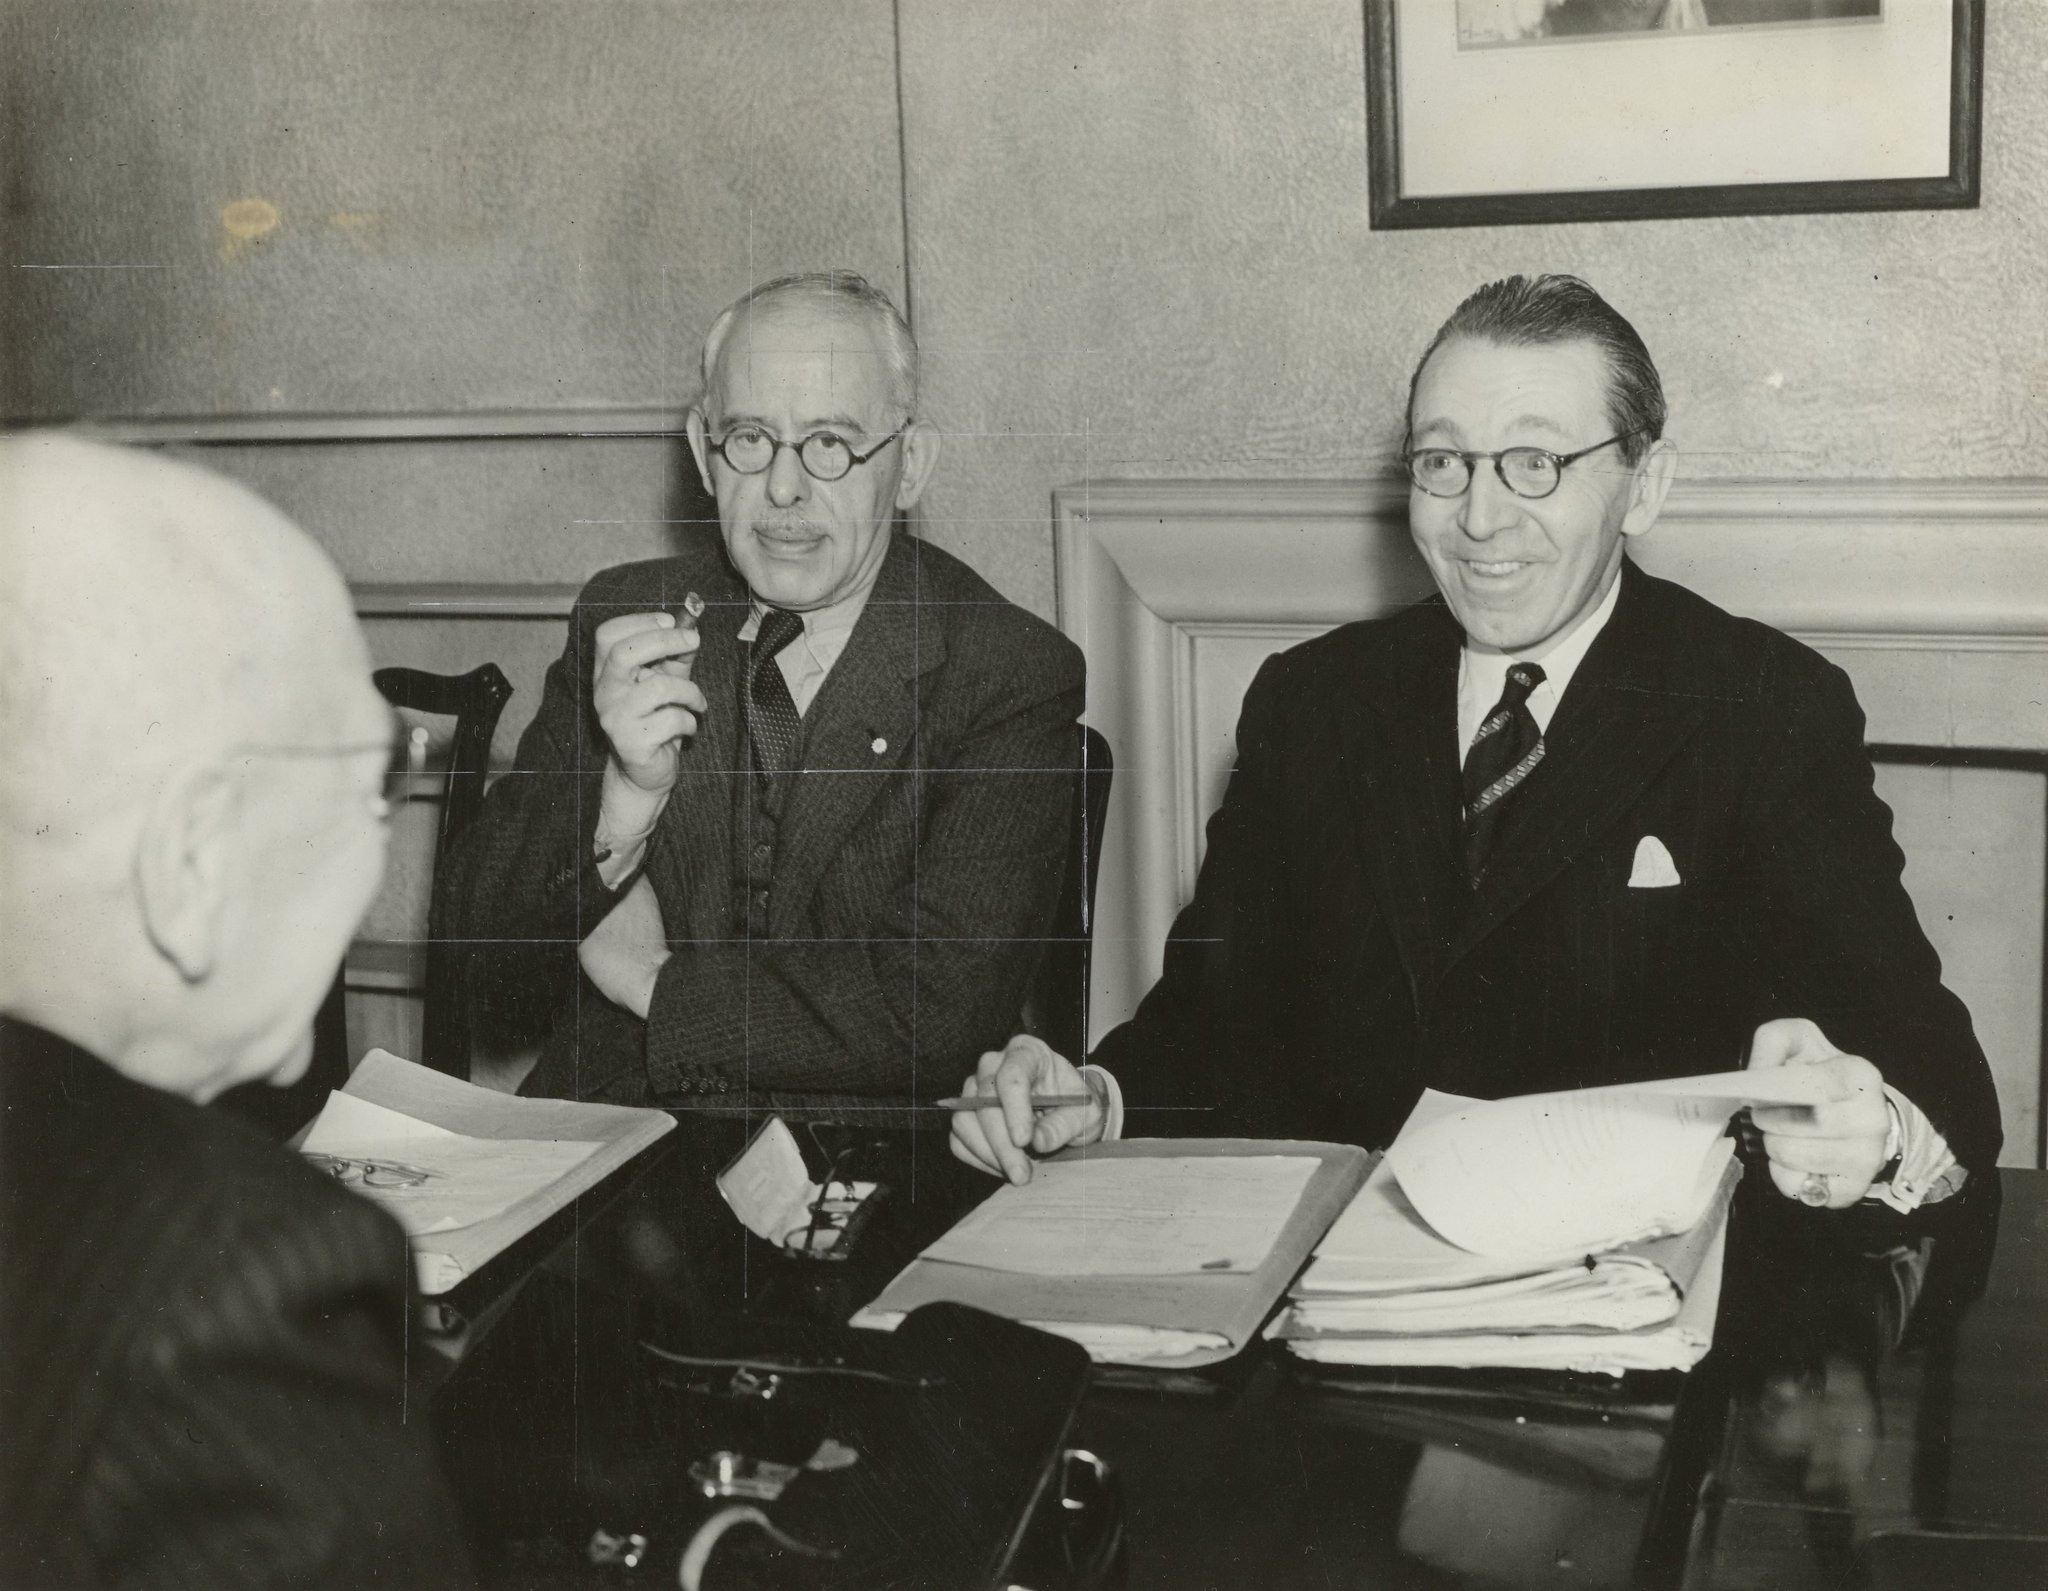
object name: photograph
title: Minister J. van Angeren en minister H. van Boeijen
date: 1940-1945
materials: photographic support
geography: london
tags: utrecht, the hague, london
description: Minister van justitie J.R.M van Angeren (rechts) en minister van binnenlandse zaken H. van Boeijen (links) tijdens de ministerraad in Stratton House in Londen. Het lijnennet is aangebracht door kunstenaar Cor Visser.